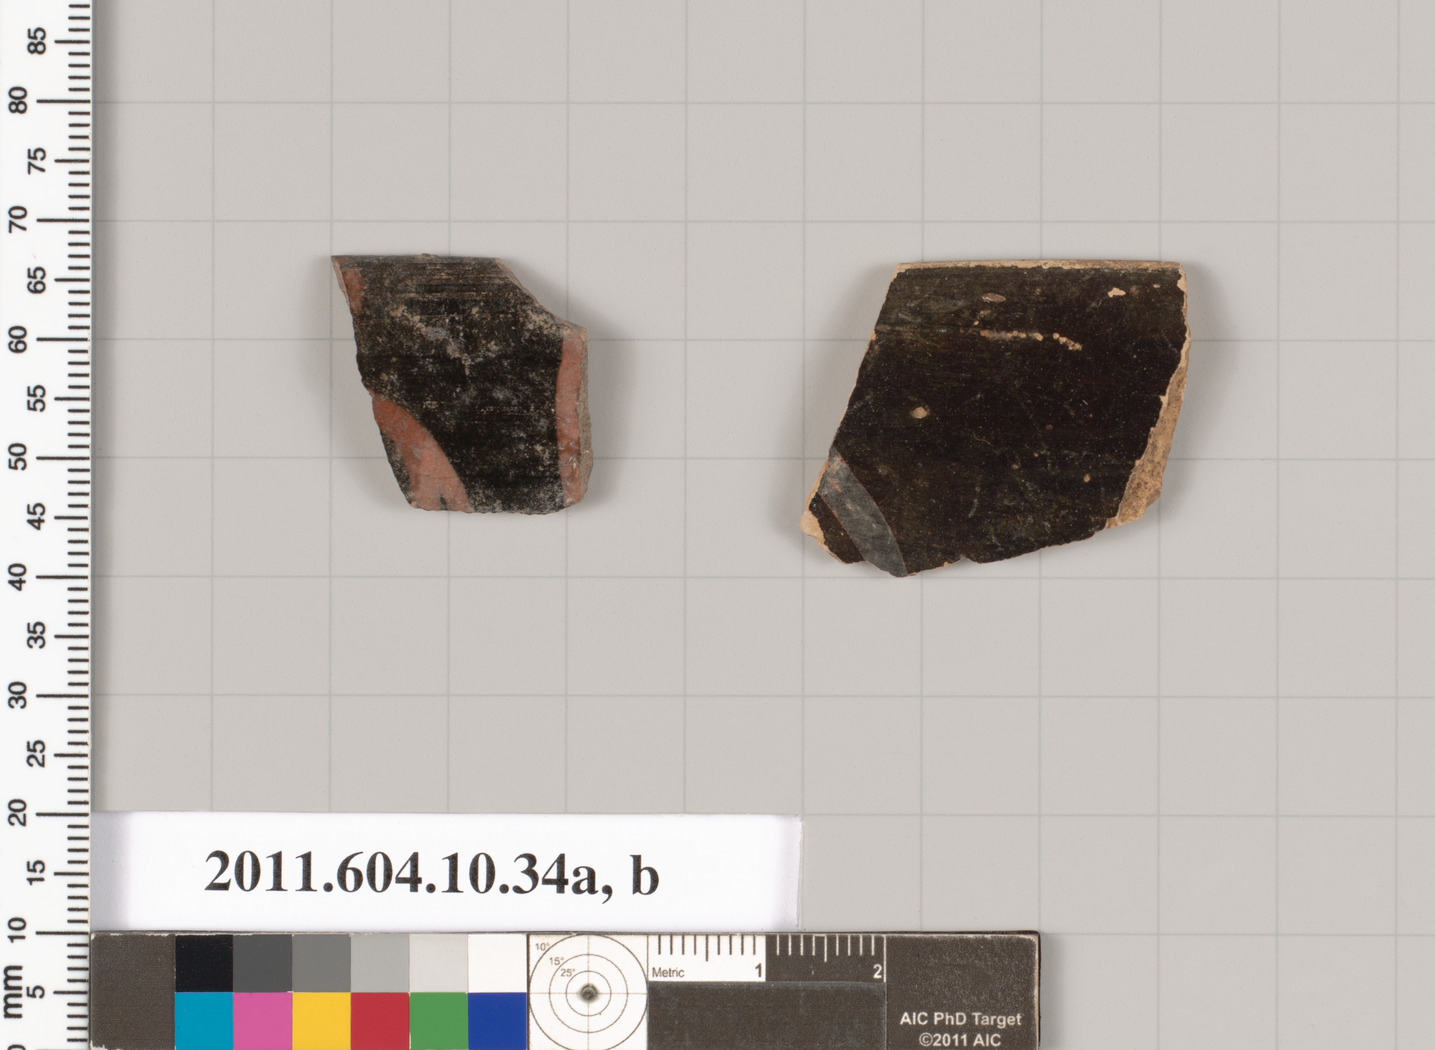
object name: kylix fragment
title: Terracotta rim fragments of kylikes (drinking cups)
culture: etruscan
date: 434-368 BCE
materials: terracotta